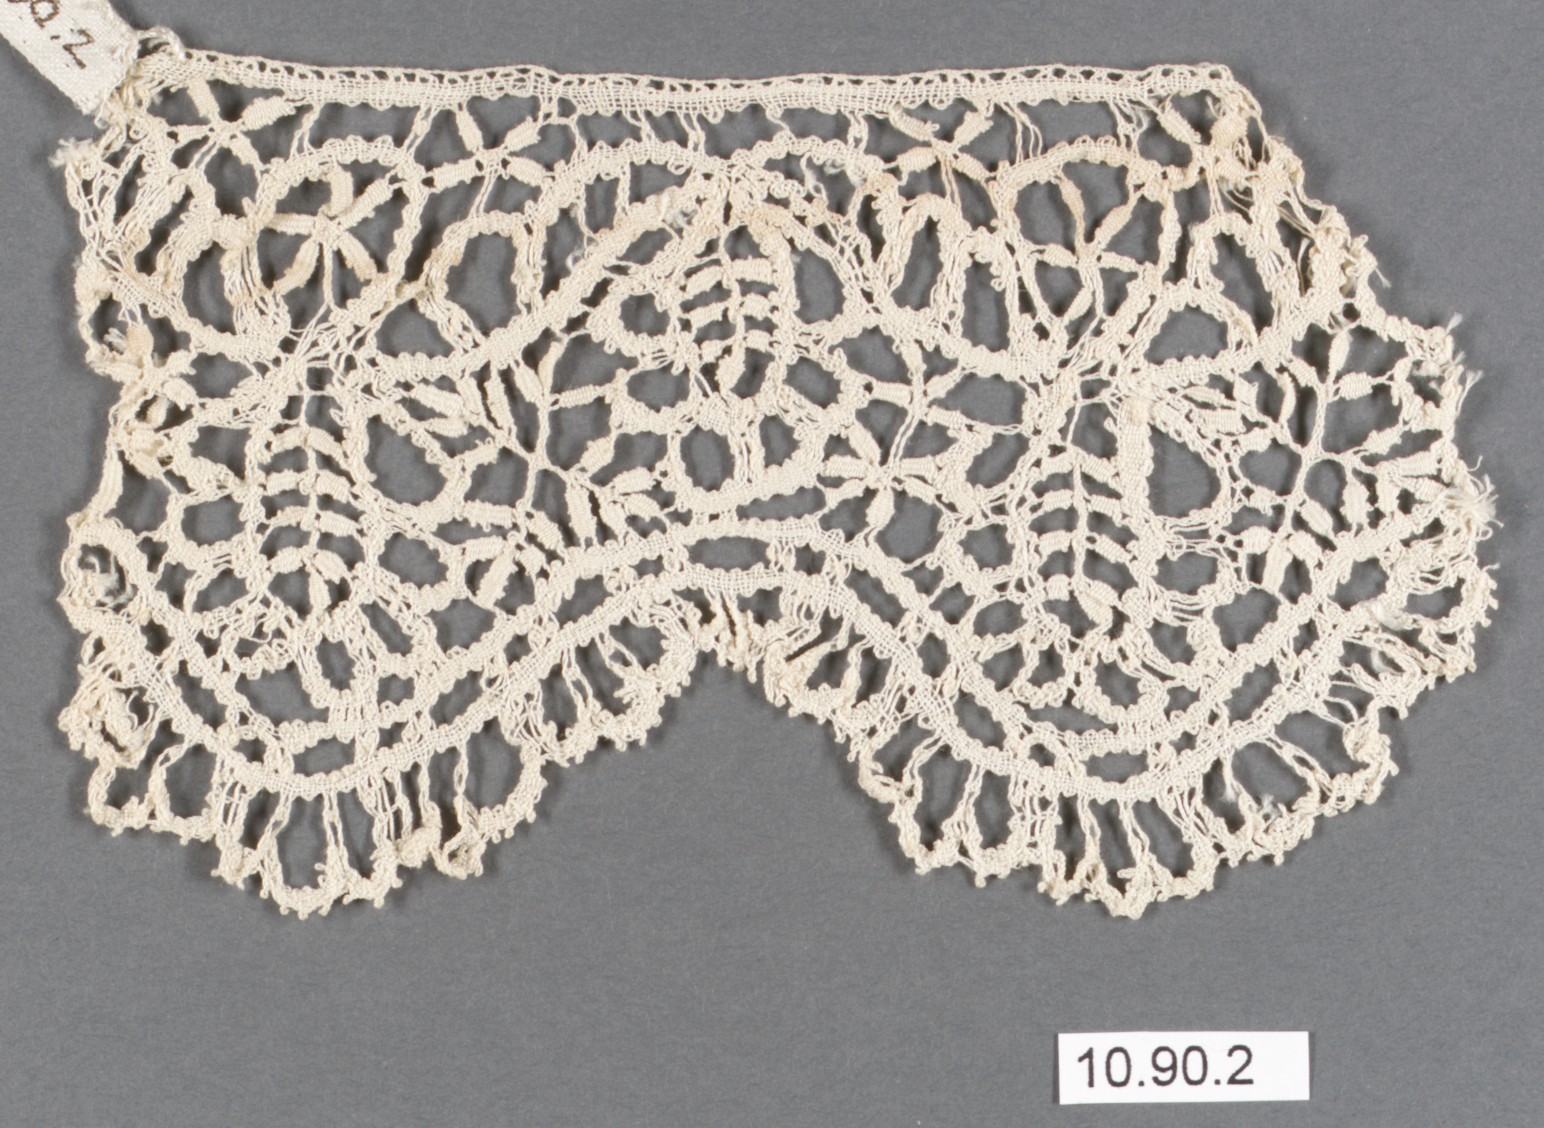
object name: piece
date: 1801-1900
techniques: lace